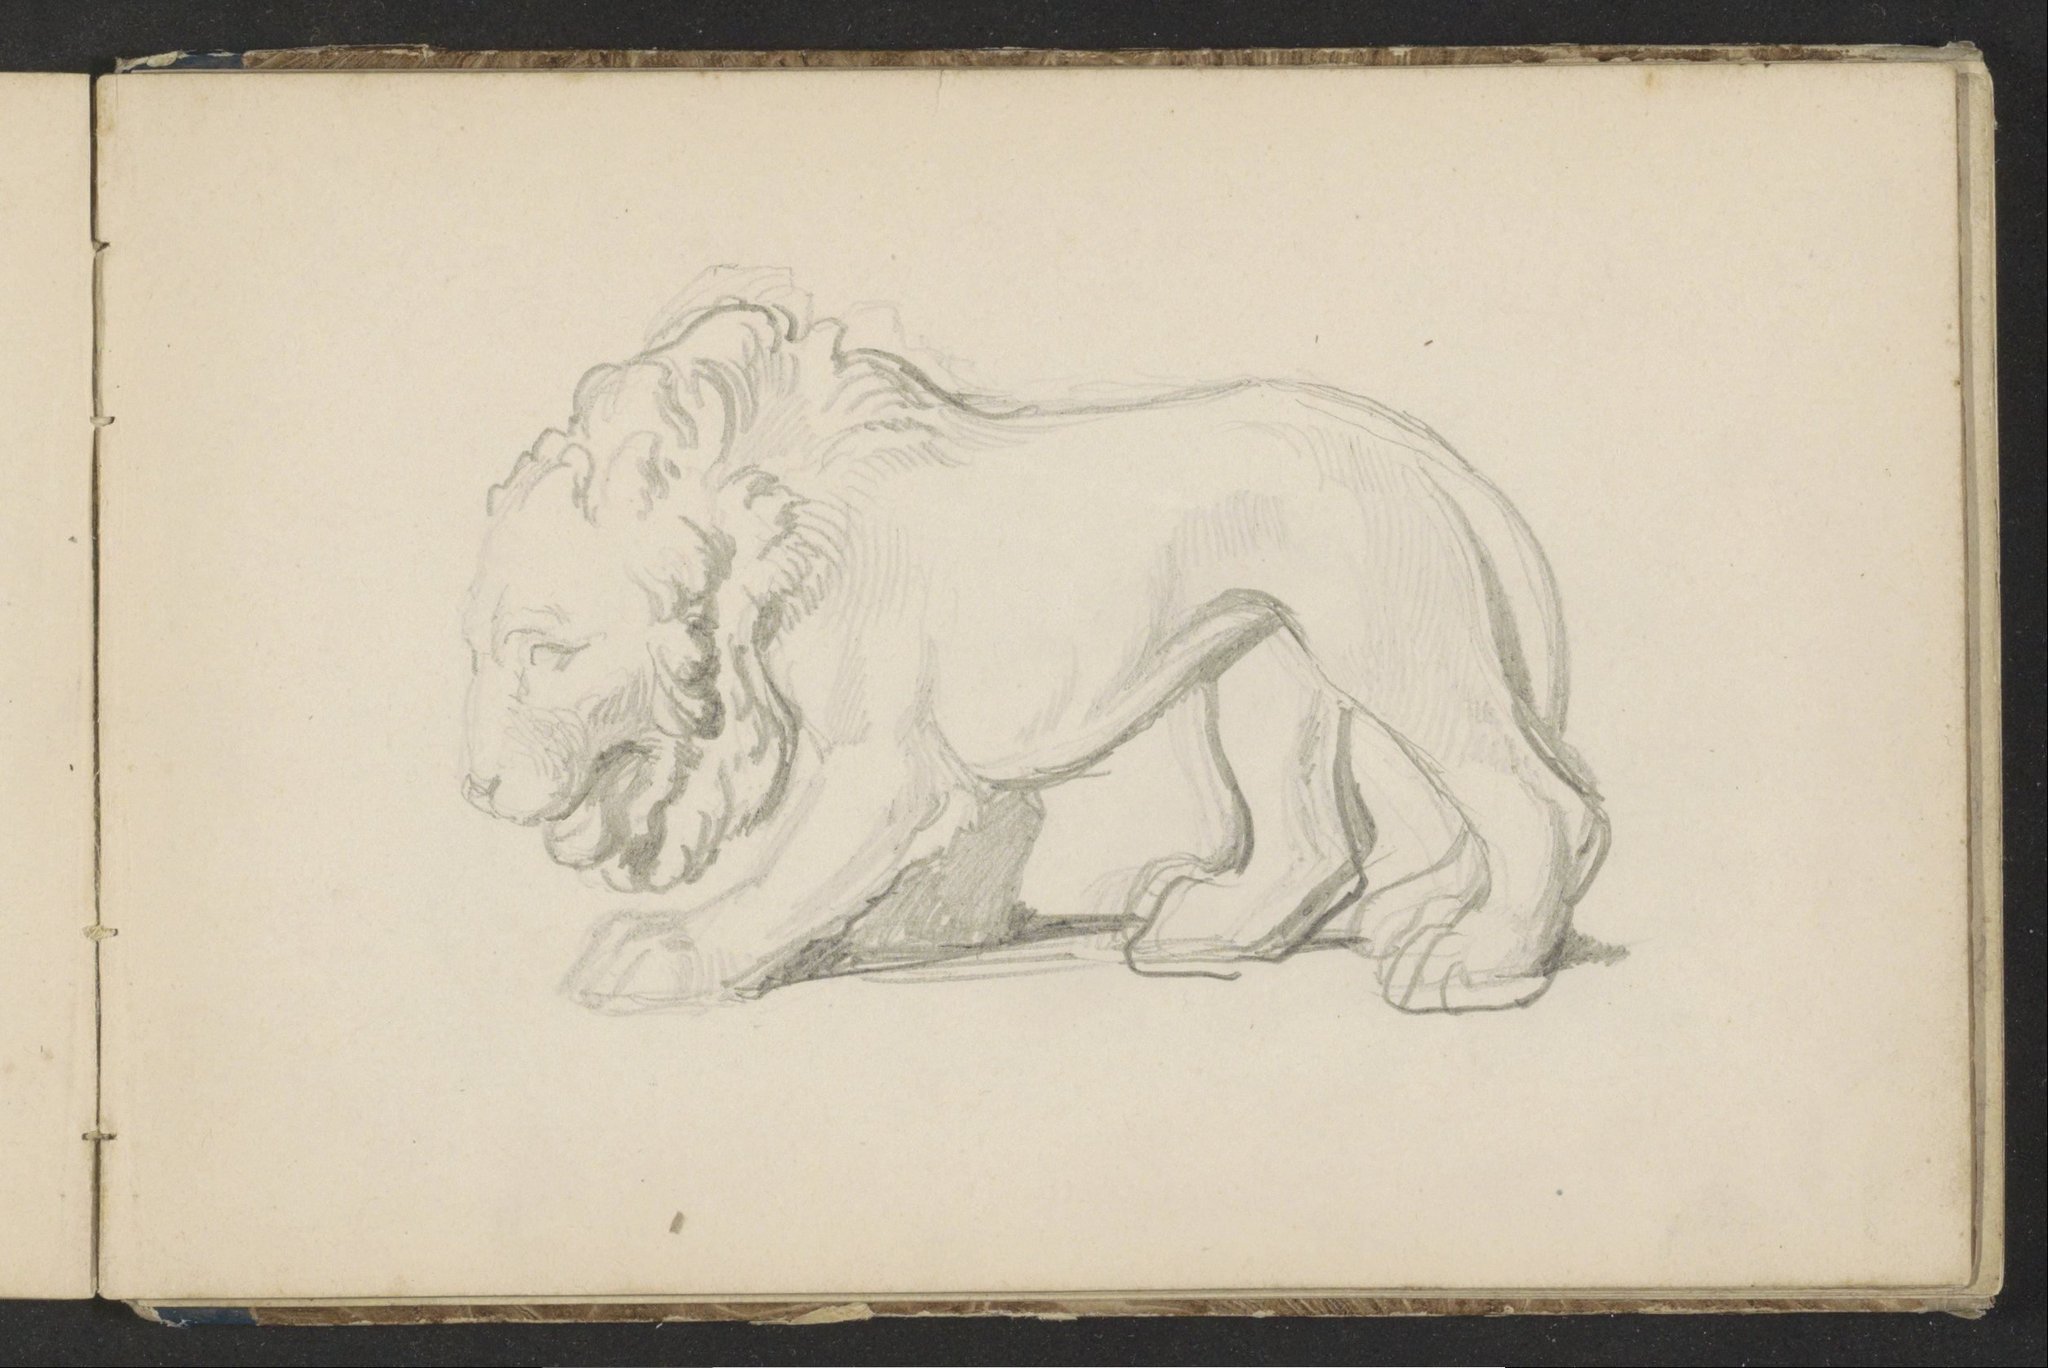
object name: sketchbook leaf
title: Leeuw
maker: Anonymous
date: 1841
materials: paper, pencil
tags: lion's den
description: Blad 15 recto uit een schetsboek met 33 bladen.